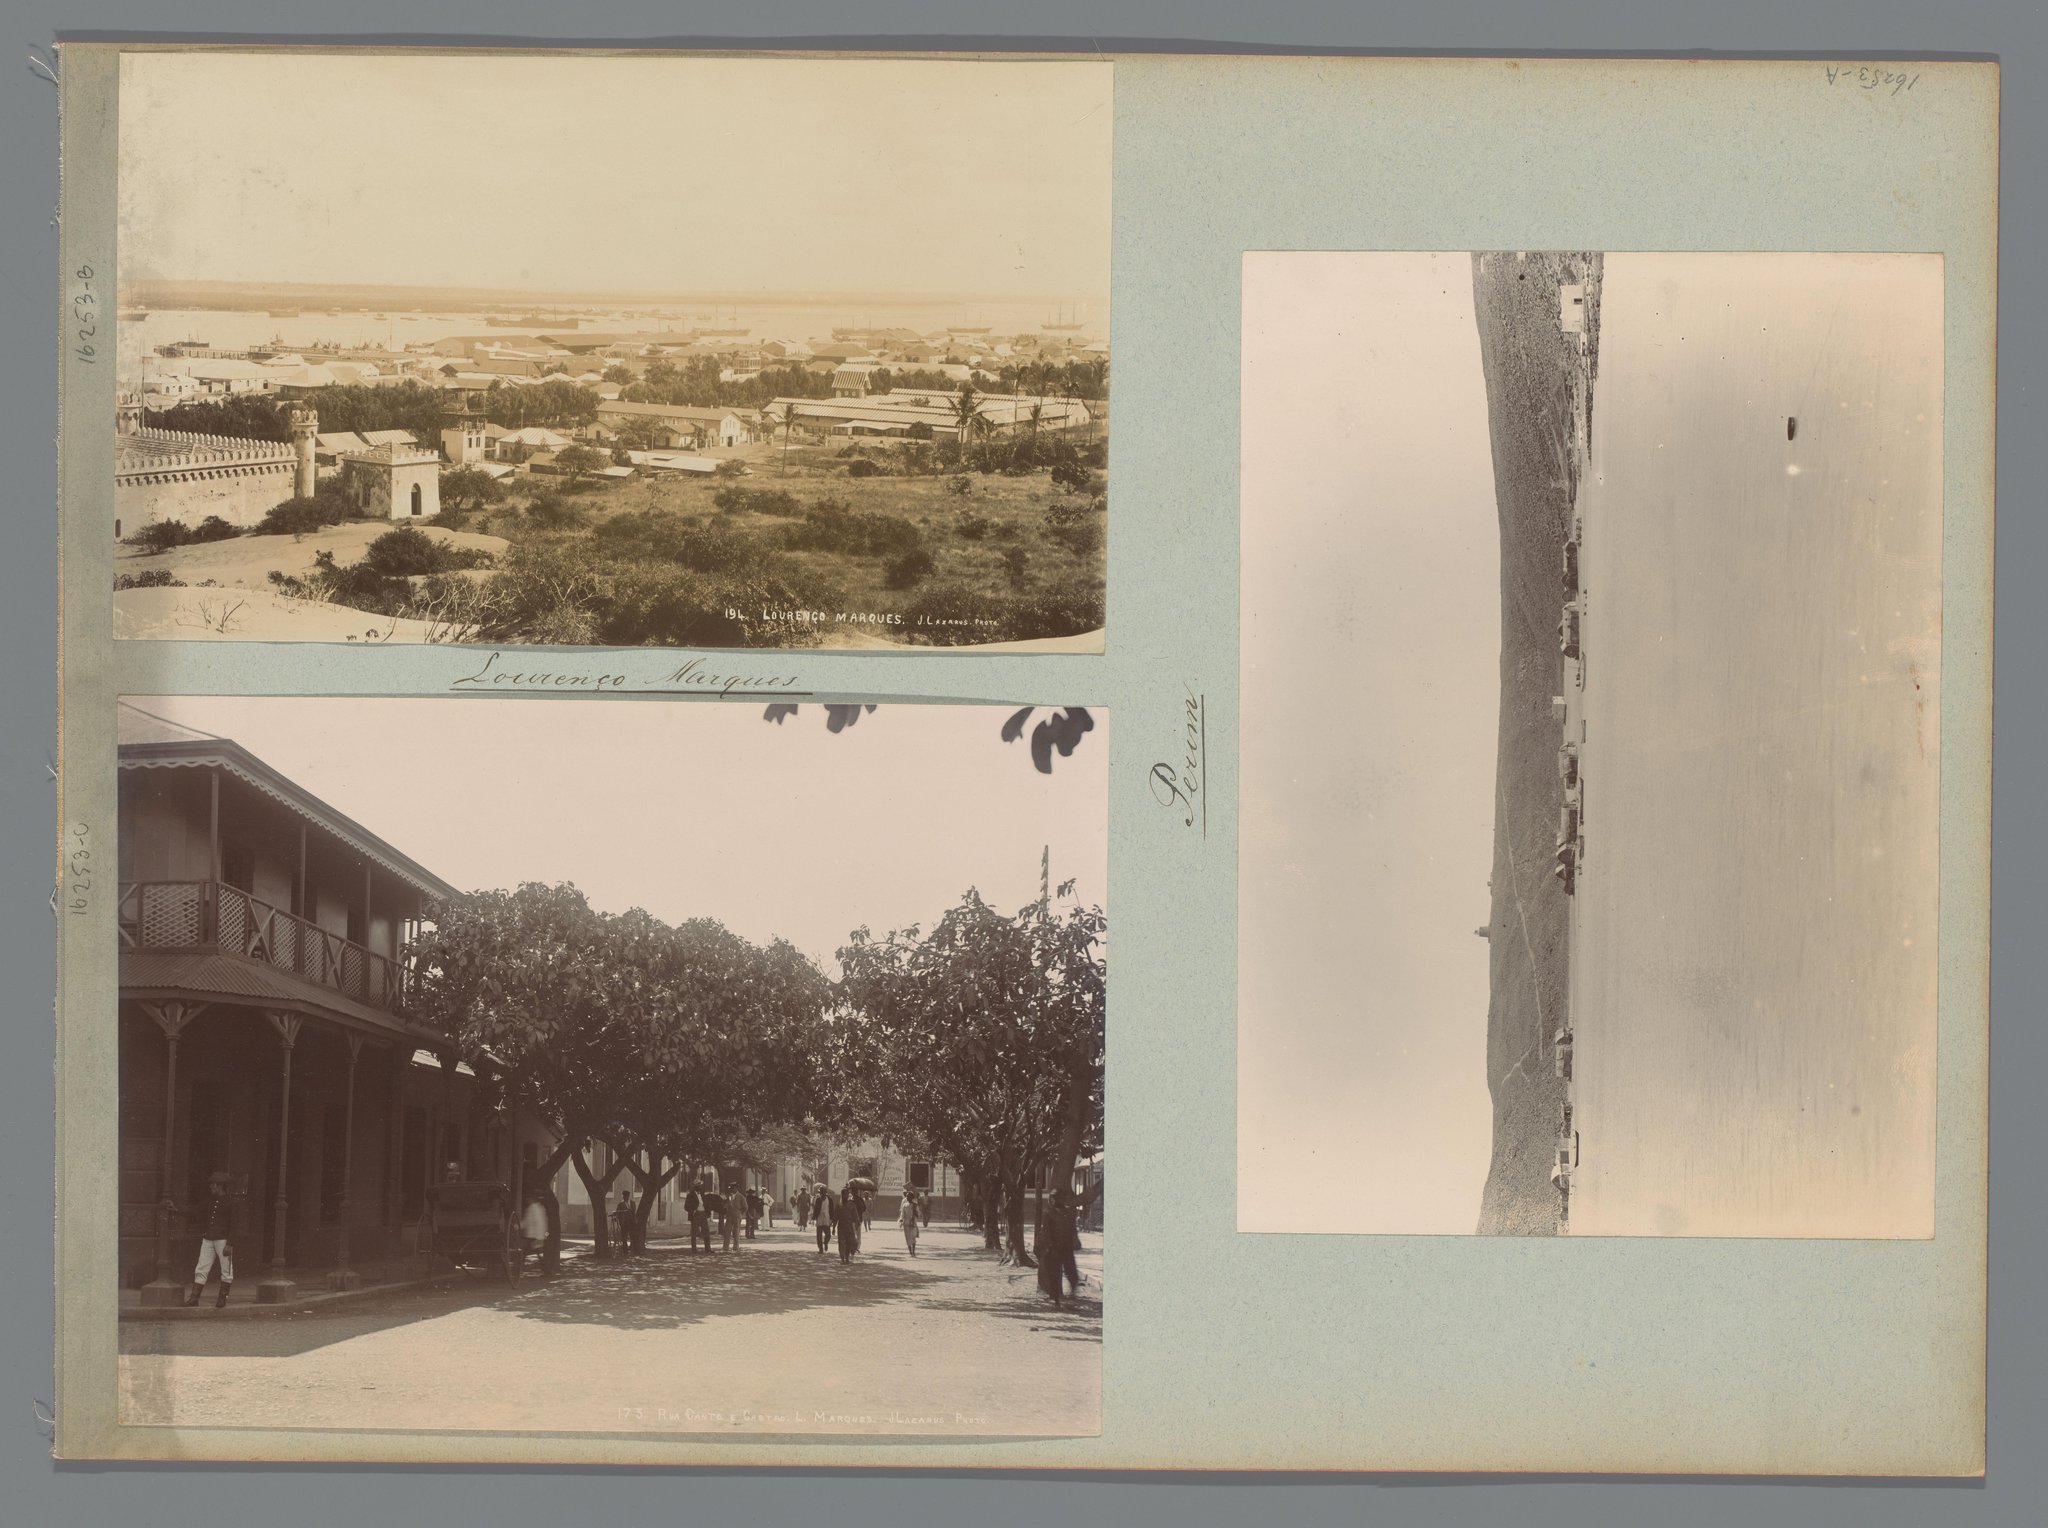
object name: sheet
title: Blad met drie foto's van Perim en Lourenço Marques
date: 1904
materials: paper, cardboard, ink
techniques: writing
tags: city-view in general; 'veduta'